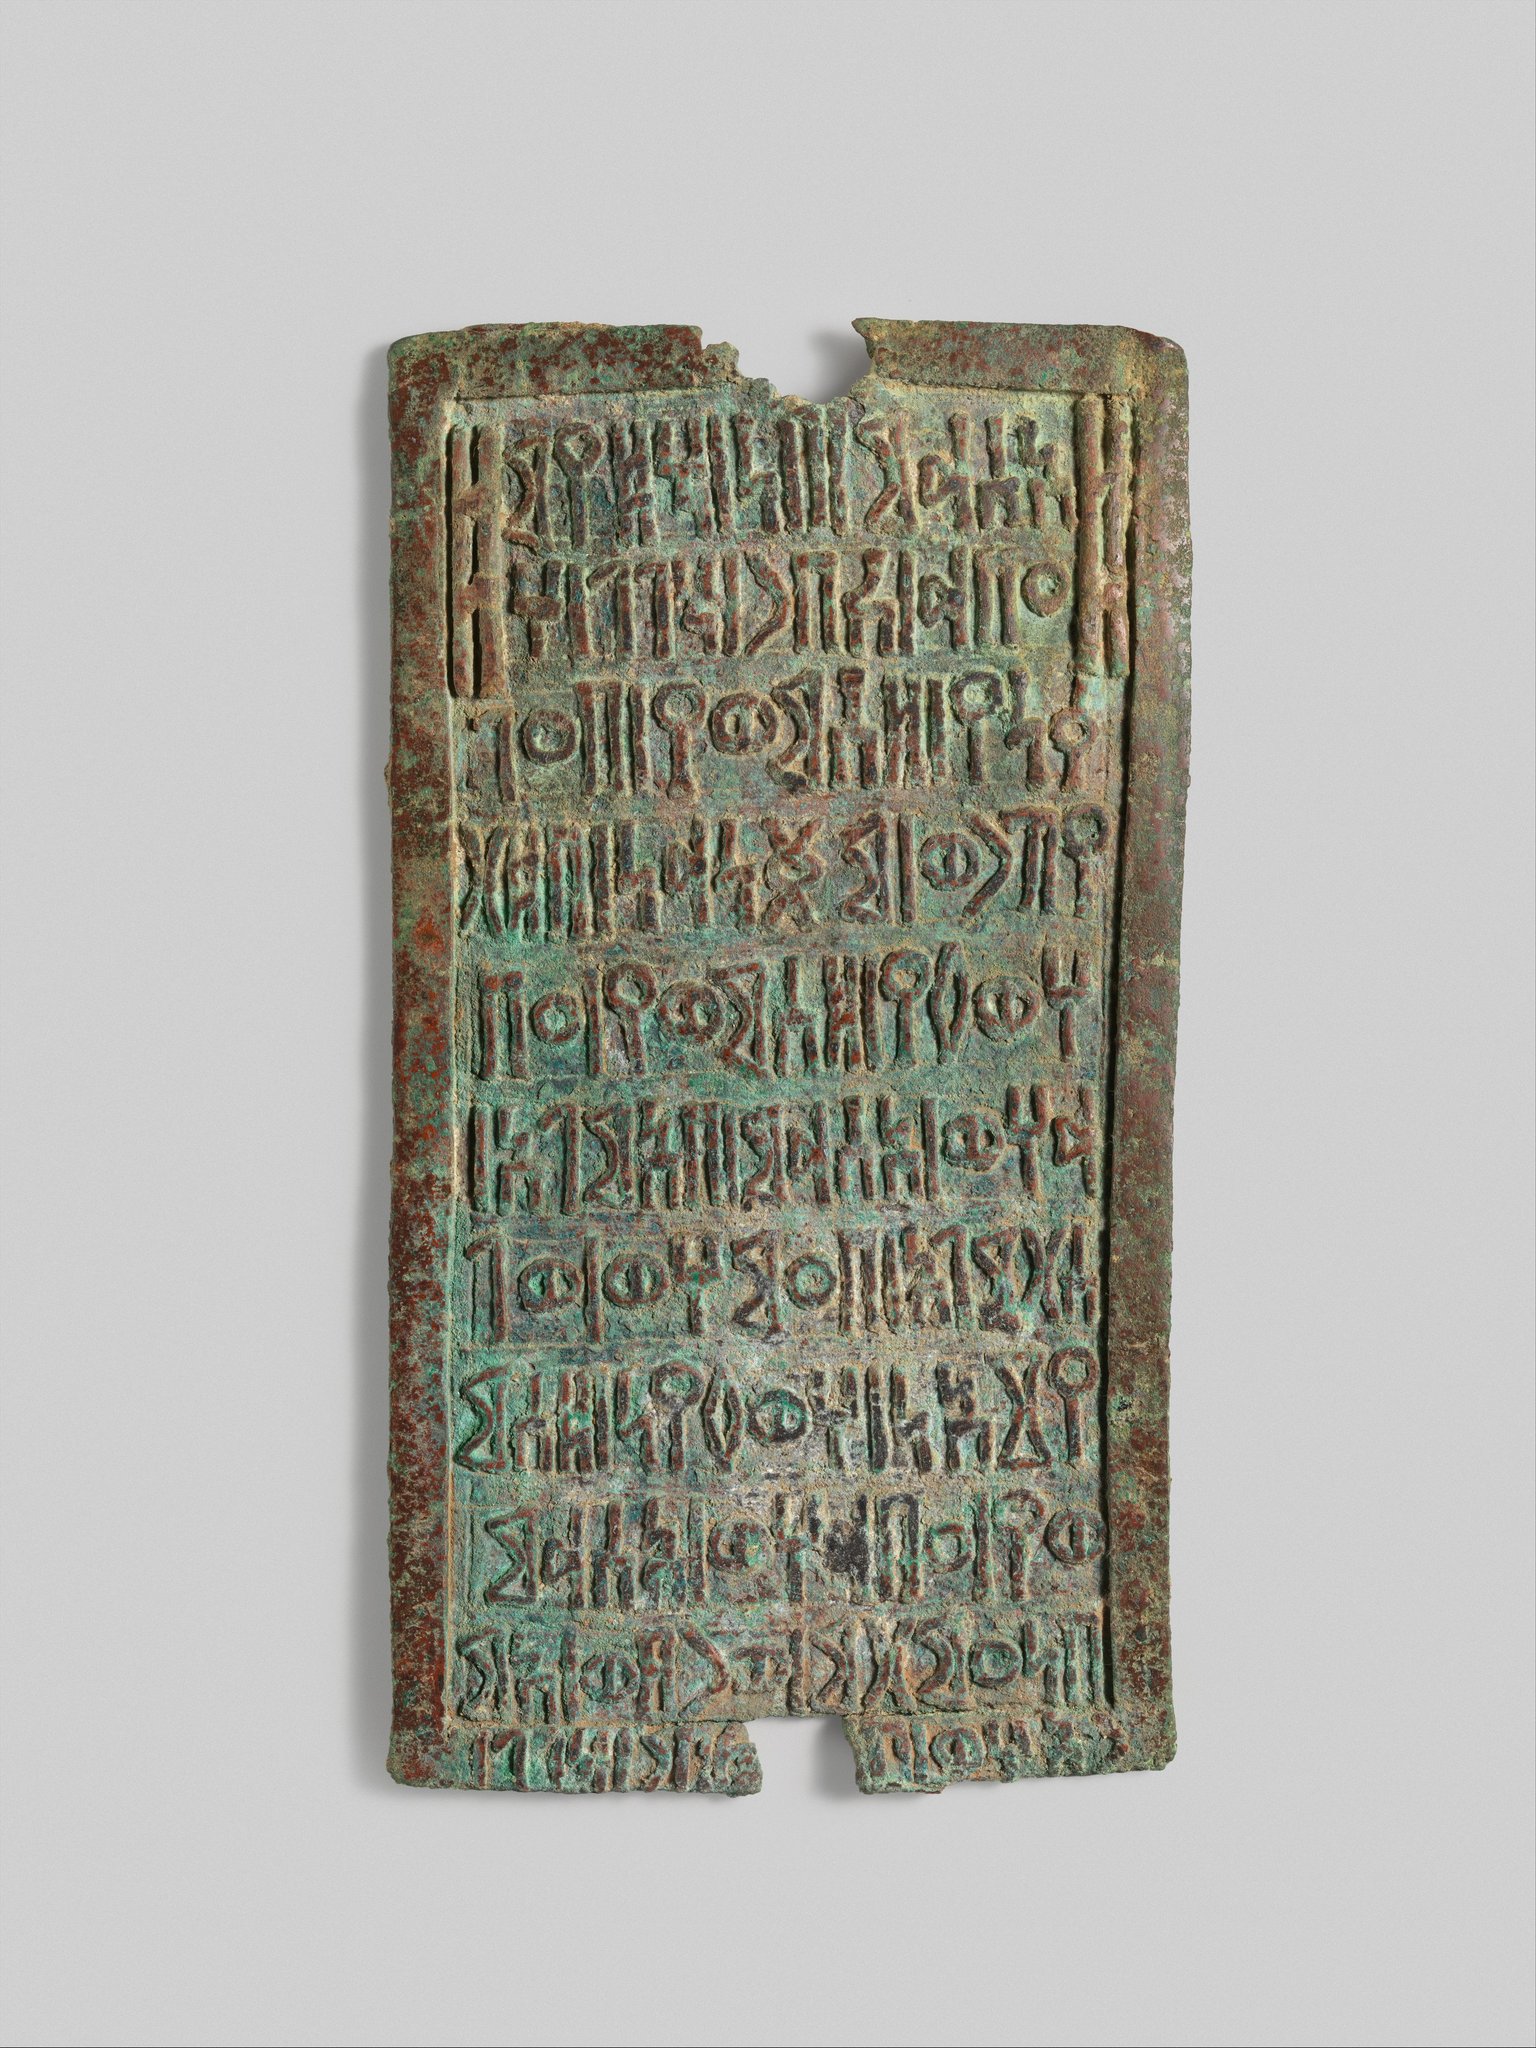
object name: relief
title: Votive plaque inscribed with Sabaean dedication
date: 333-1 BCE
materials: copper alloy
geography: southwestern arabia